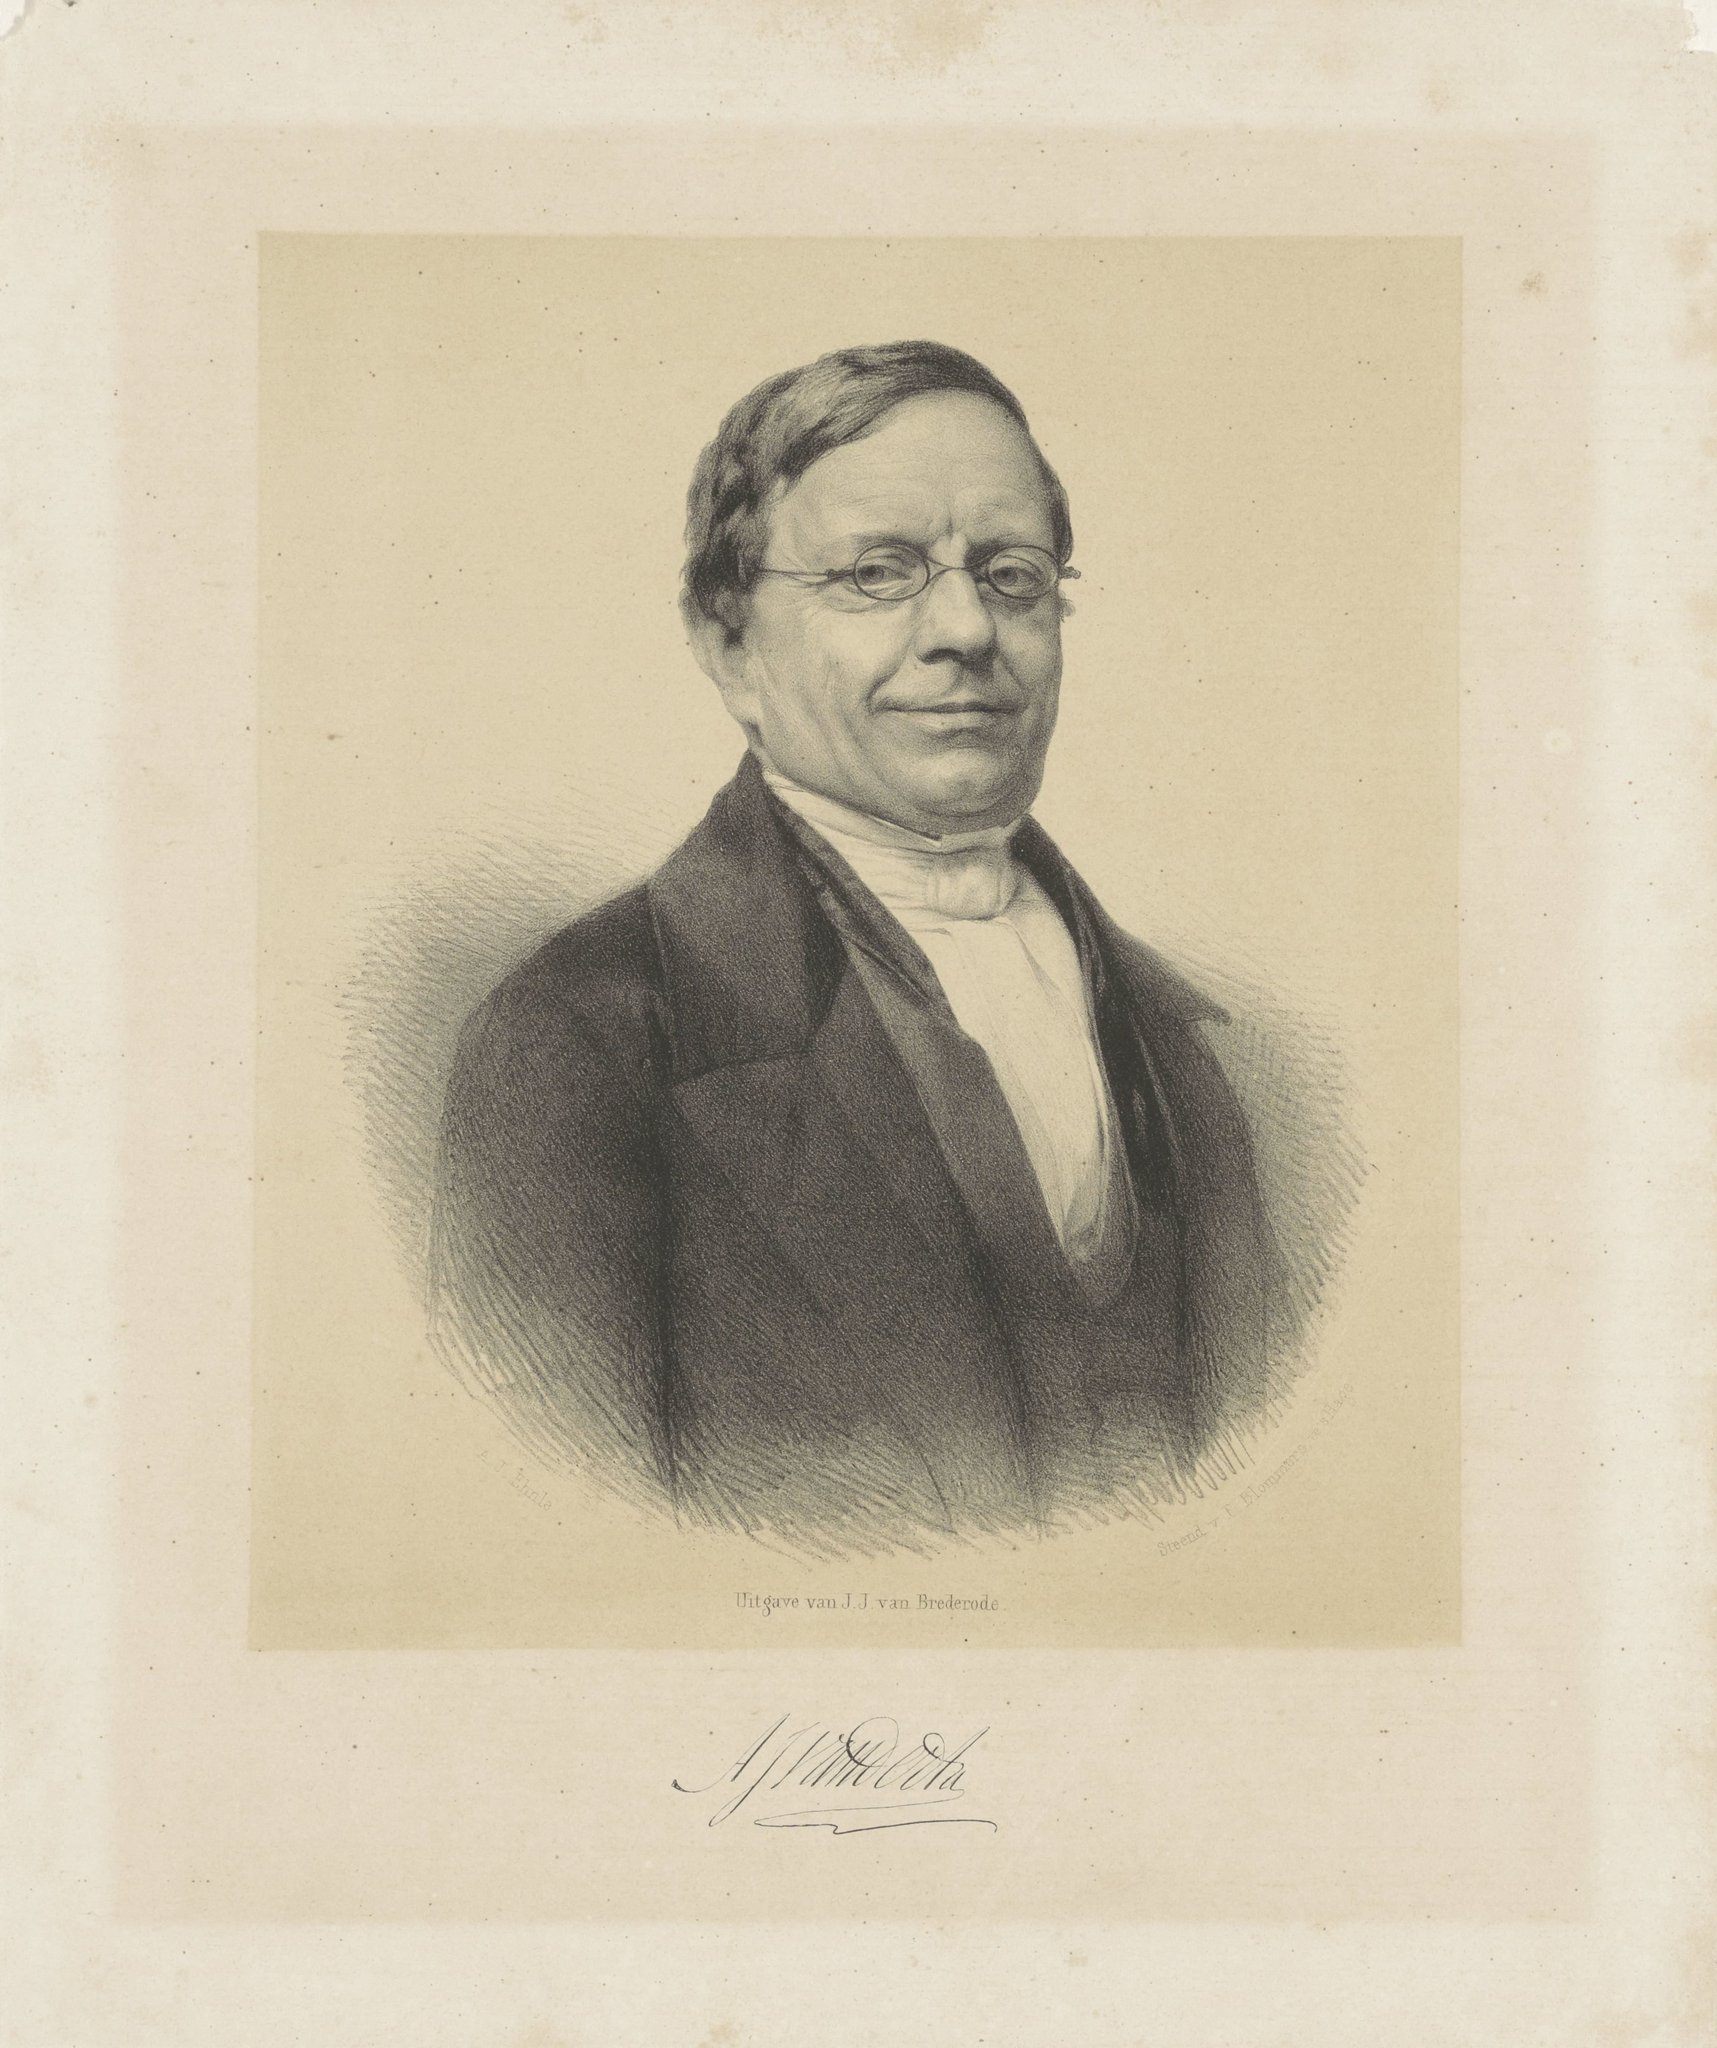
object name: print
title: Portret van Abraham Jacob van der Aa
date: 1842-1883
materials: paper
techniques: tone lithography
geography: the hague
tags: amsterdam, eyeglasses, spectacles, historical persons (+ (full) bust portrait)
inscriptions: collector's mark: Lugt 2228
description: De geportretteerde draagt een bril. Onder het portret zijn signatuur.